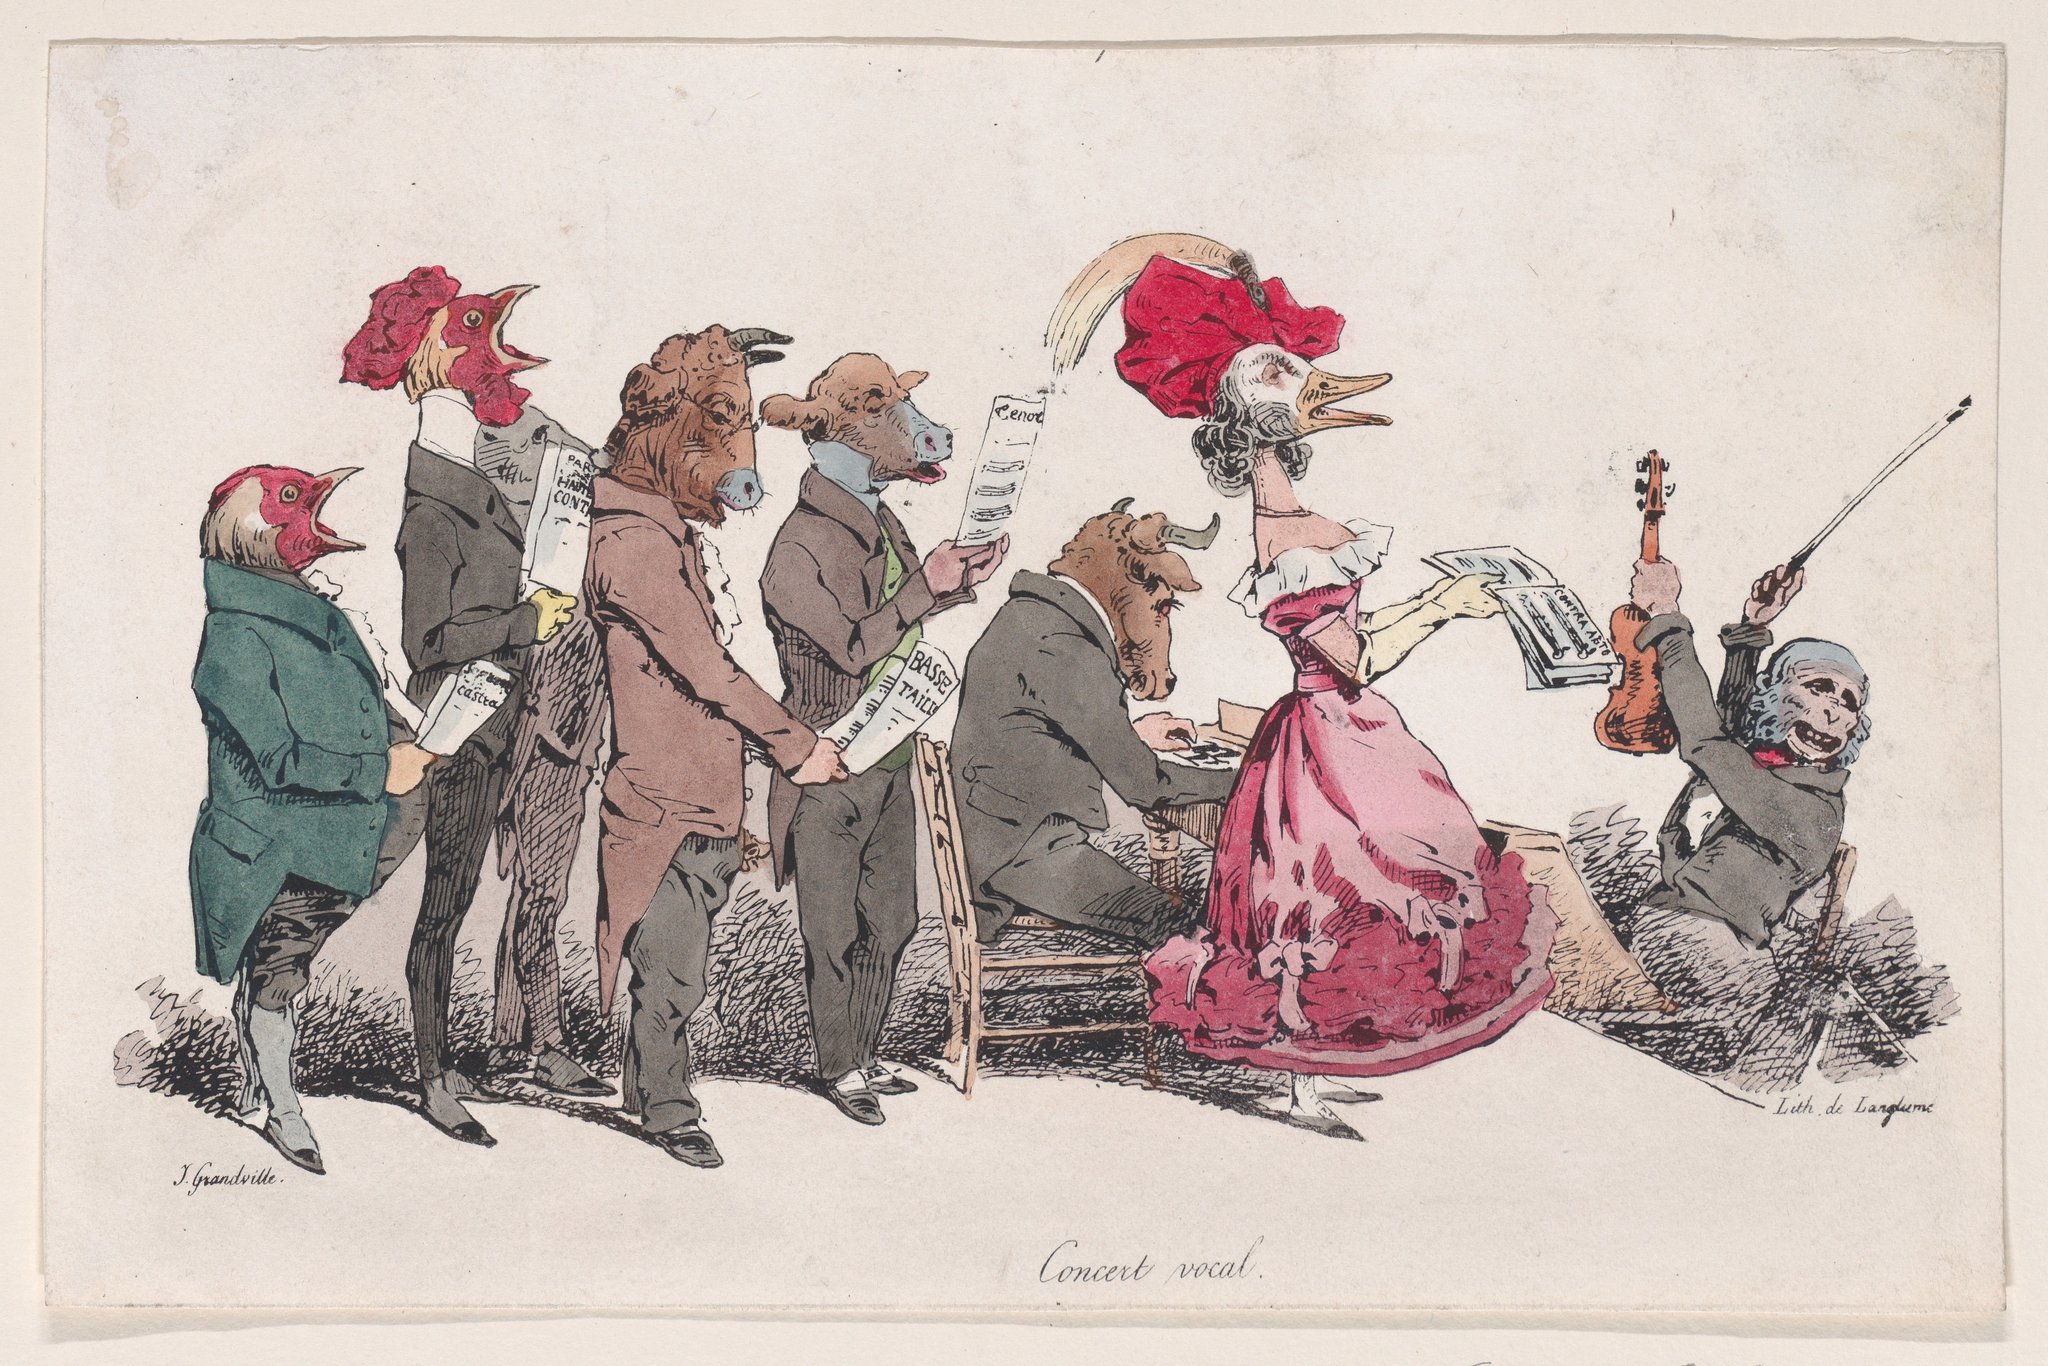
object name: print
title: Vocal Concert, from "Metamorphoses of the Day"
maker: j. j. grandville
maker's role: designer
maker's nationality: french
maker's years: 1803-1847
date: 1829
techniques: hand coloring, lithograph